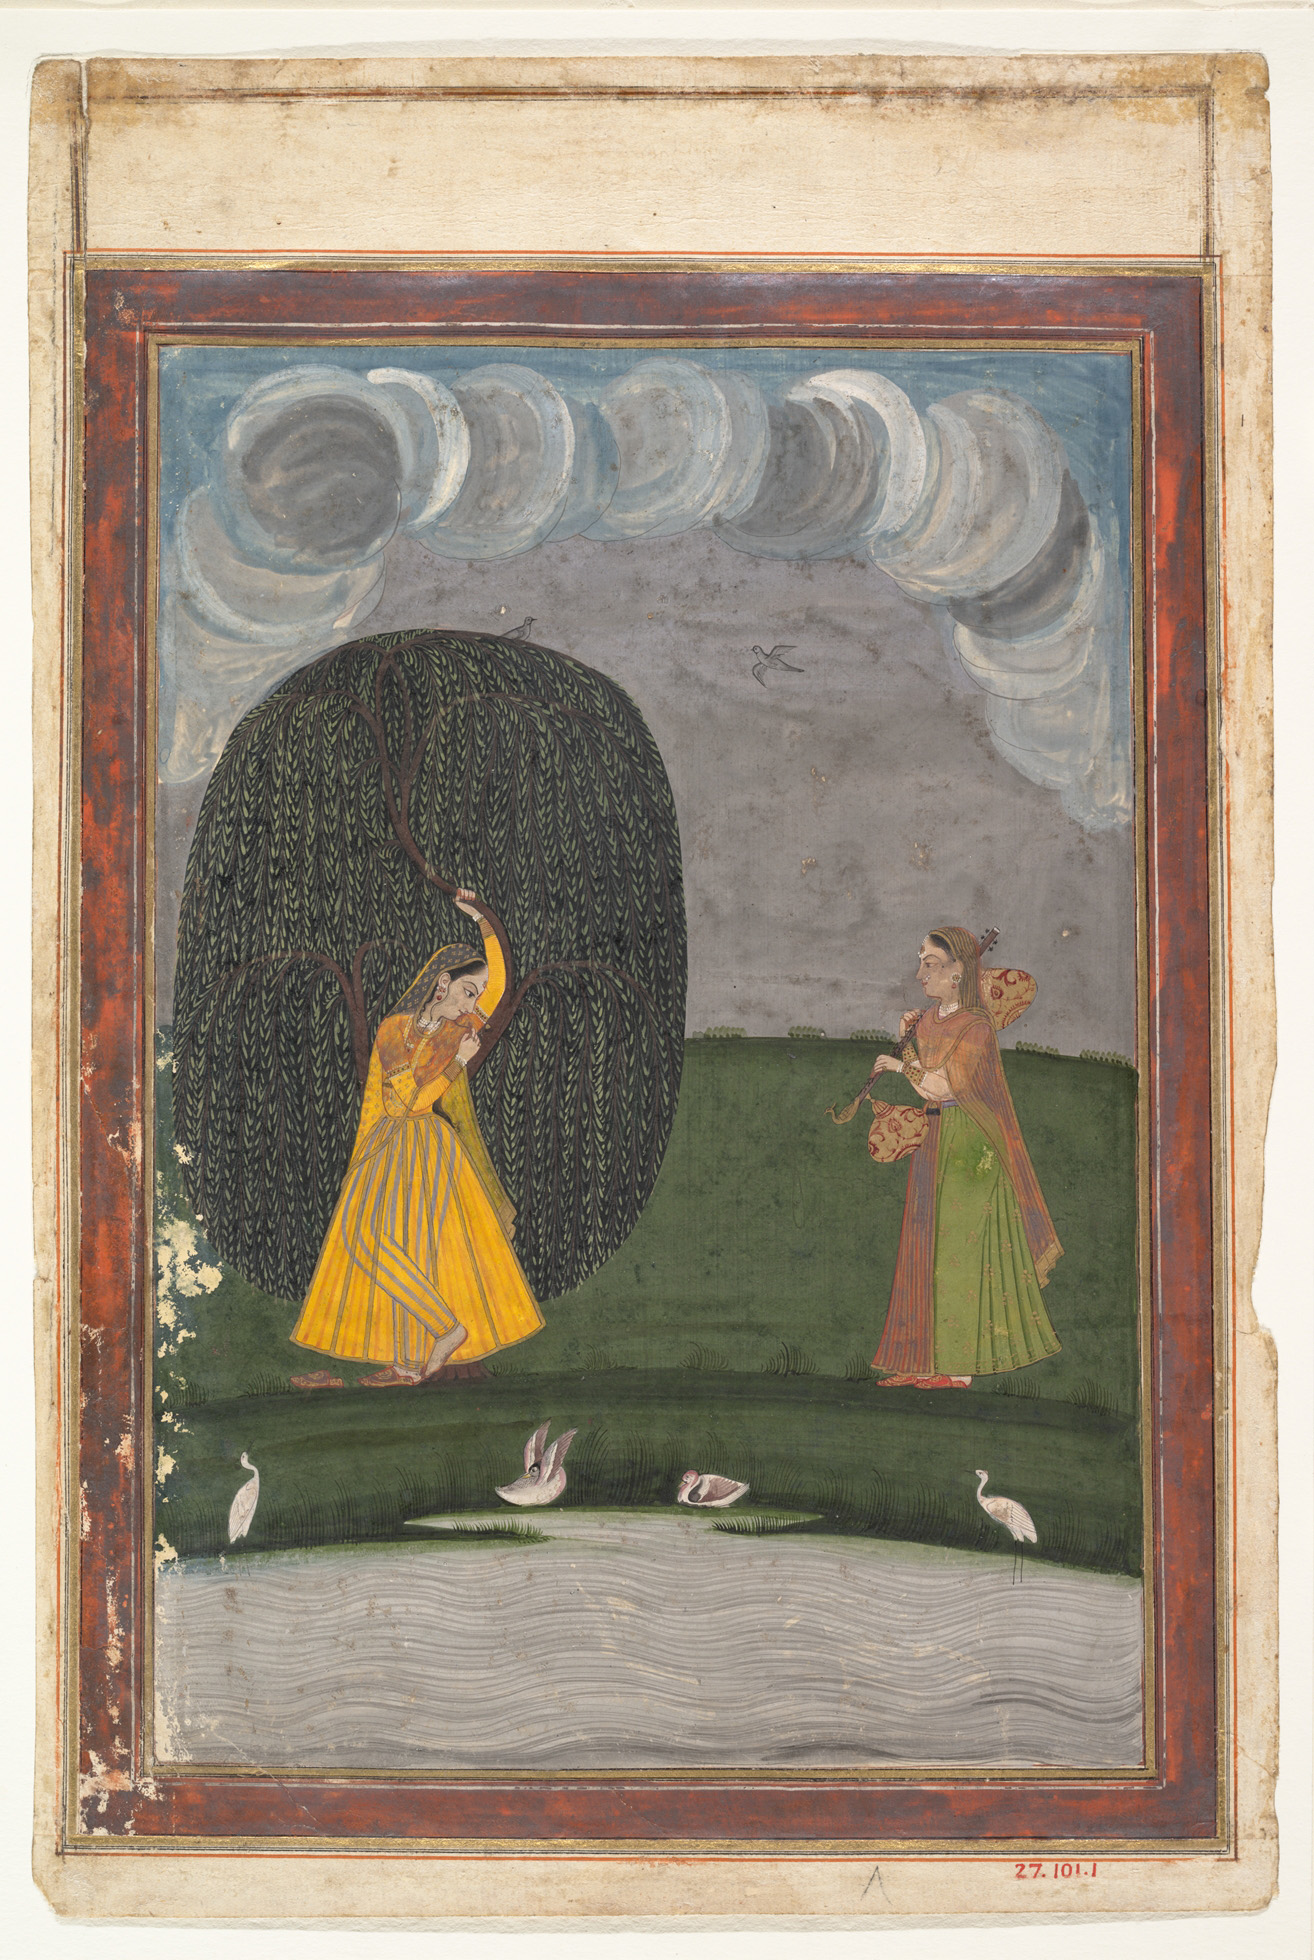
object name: painting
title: Illustration from a Ragamala Series (Garland of Musical Modes)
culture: indian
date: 1767-1800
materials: gouache, paper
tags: musical instruments,women,trees